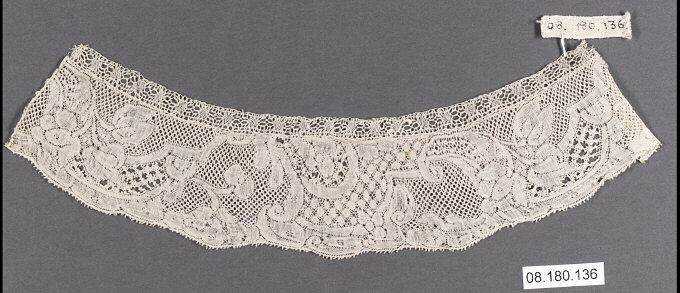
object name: piece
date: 1701-1733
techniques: lace